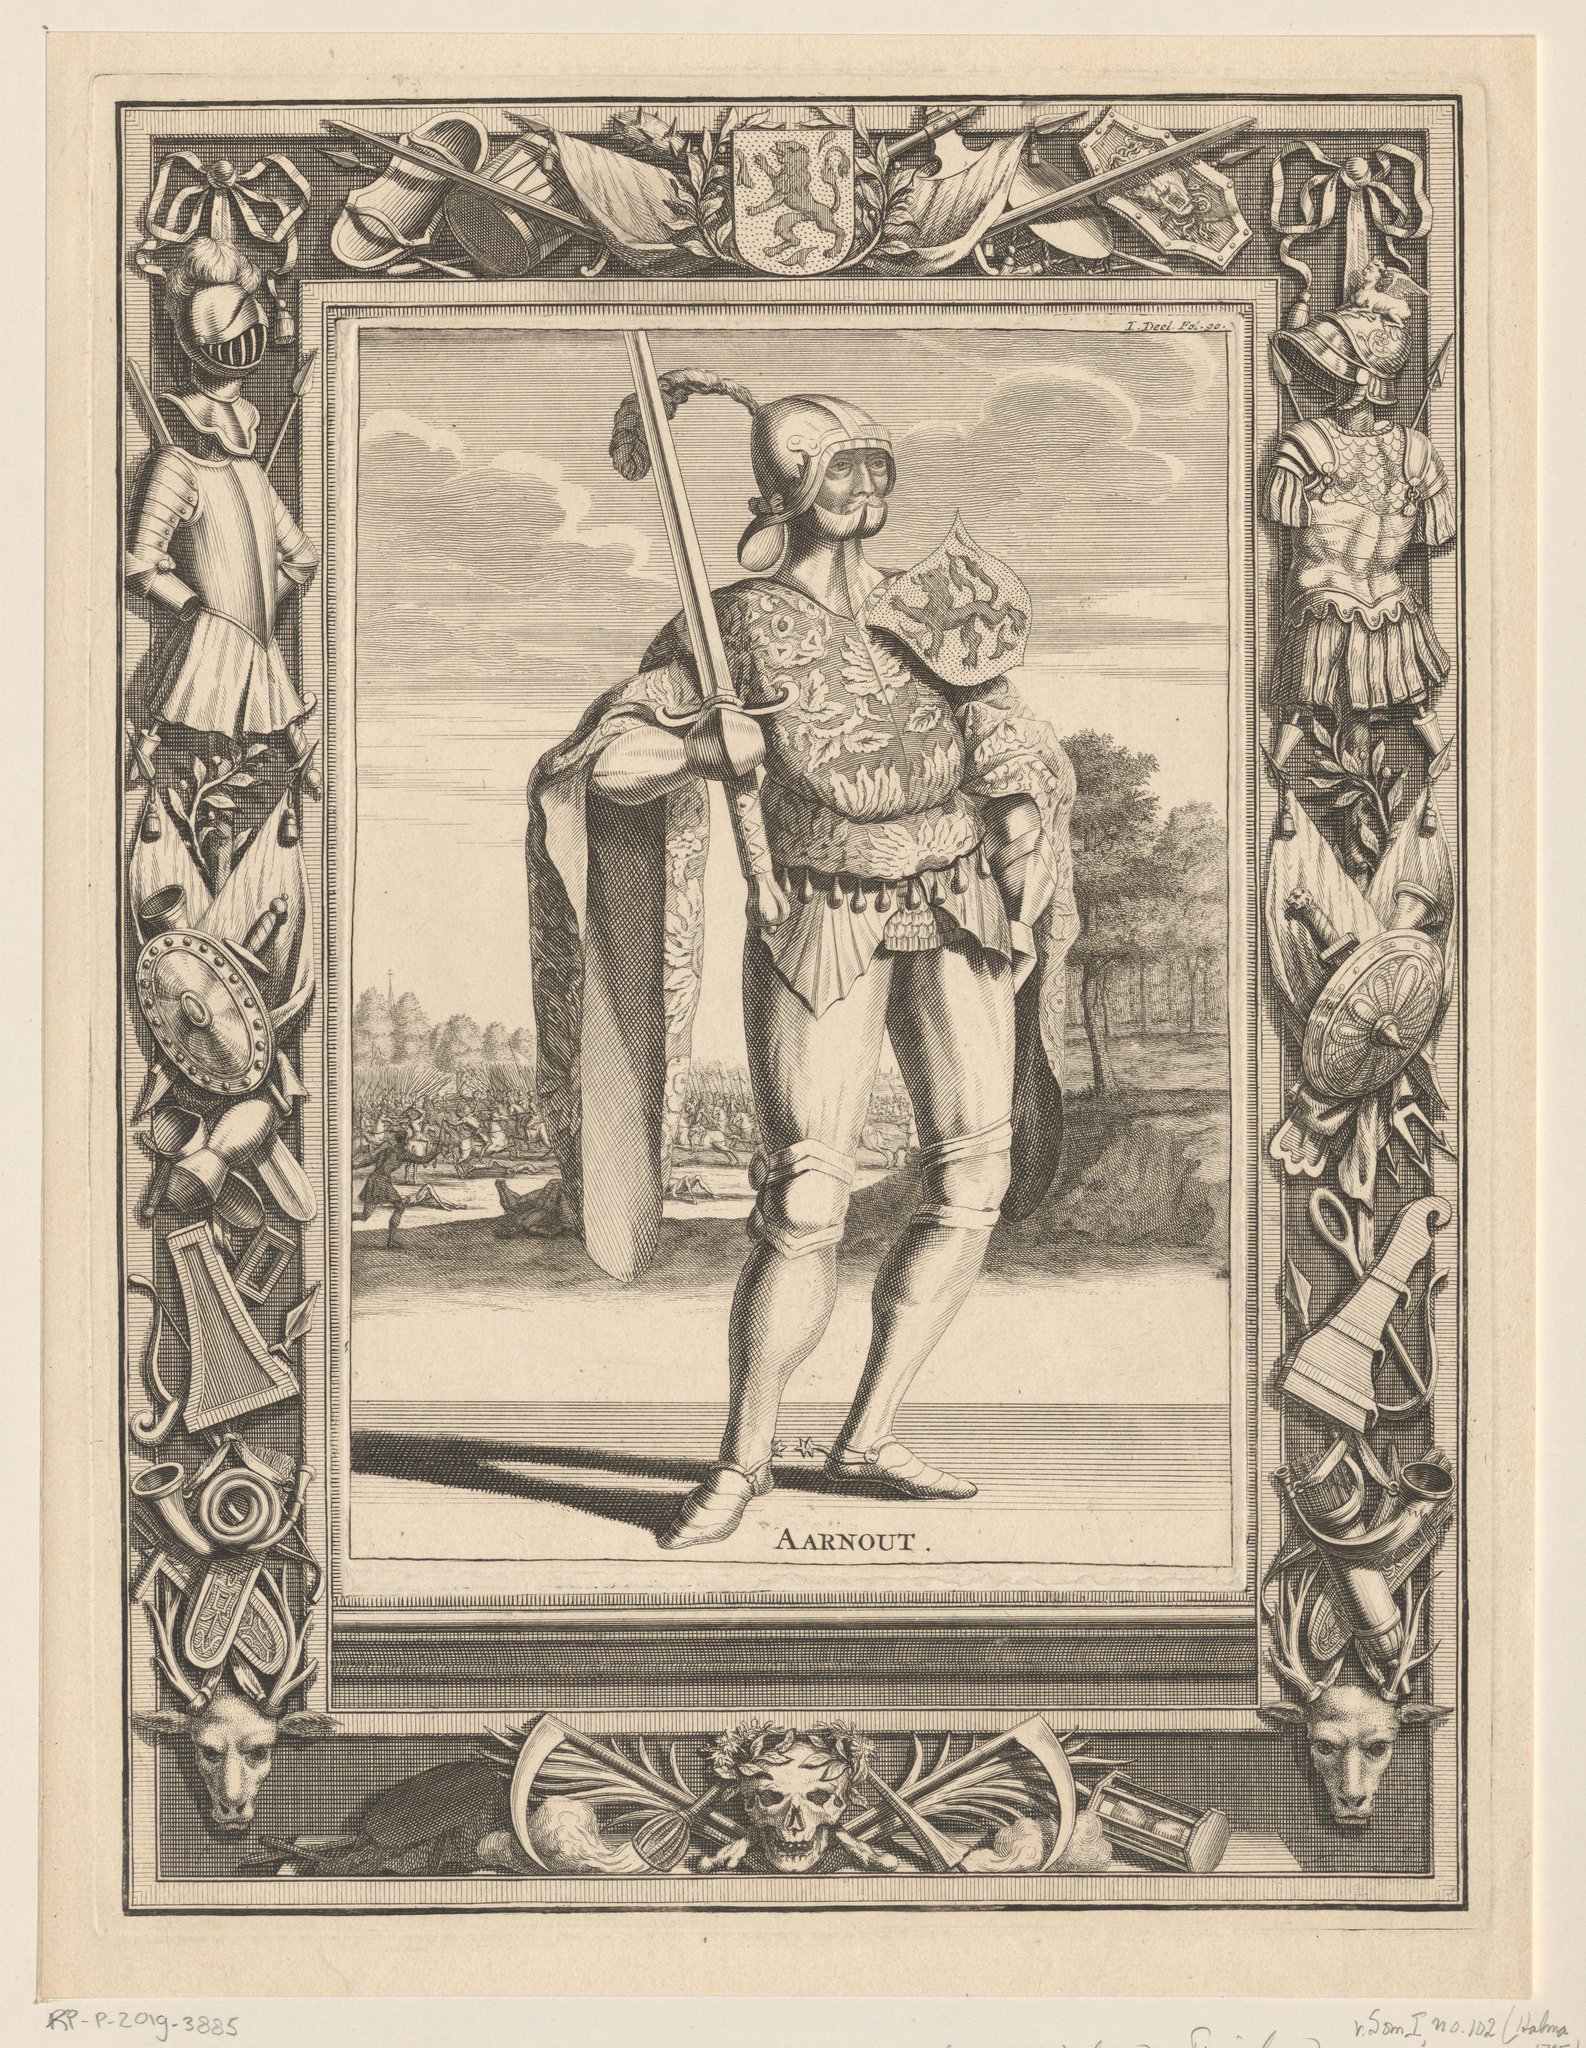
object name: book illustration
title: Portret van Arnulf, graaf van Holland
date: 1725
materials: paper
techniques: engraving, etching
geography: leeuwarden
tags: ghent, earl, armour, historical persons, armorial bearing, heraldry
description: Prent uit: Halma, François. Tooneel der Vereenigde Nederlanden en onderhorige landschappen (...). Leeuwarden: Hendrik Halma, 1725, dl. 1, p. 90.